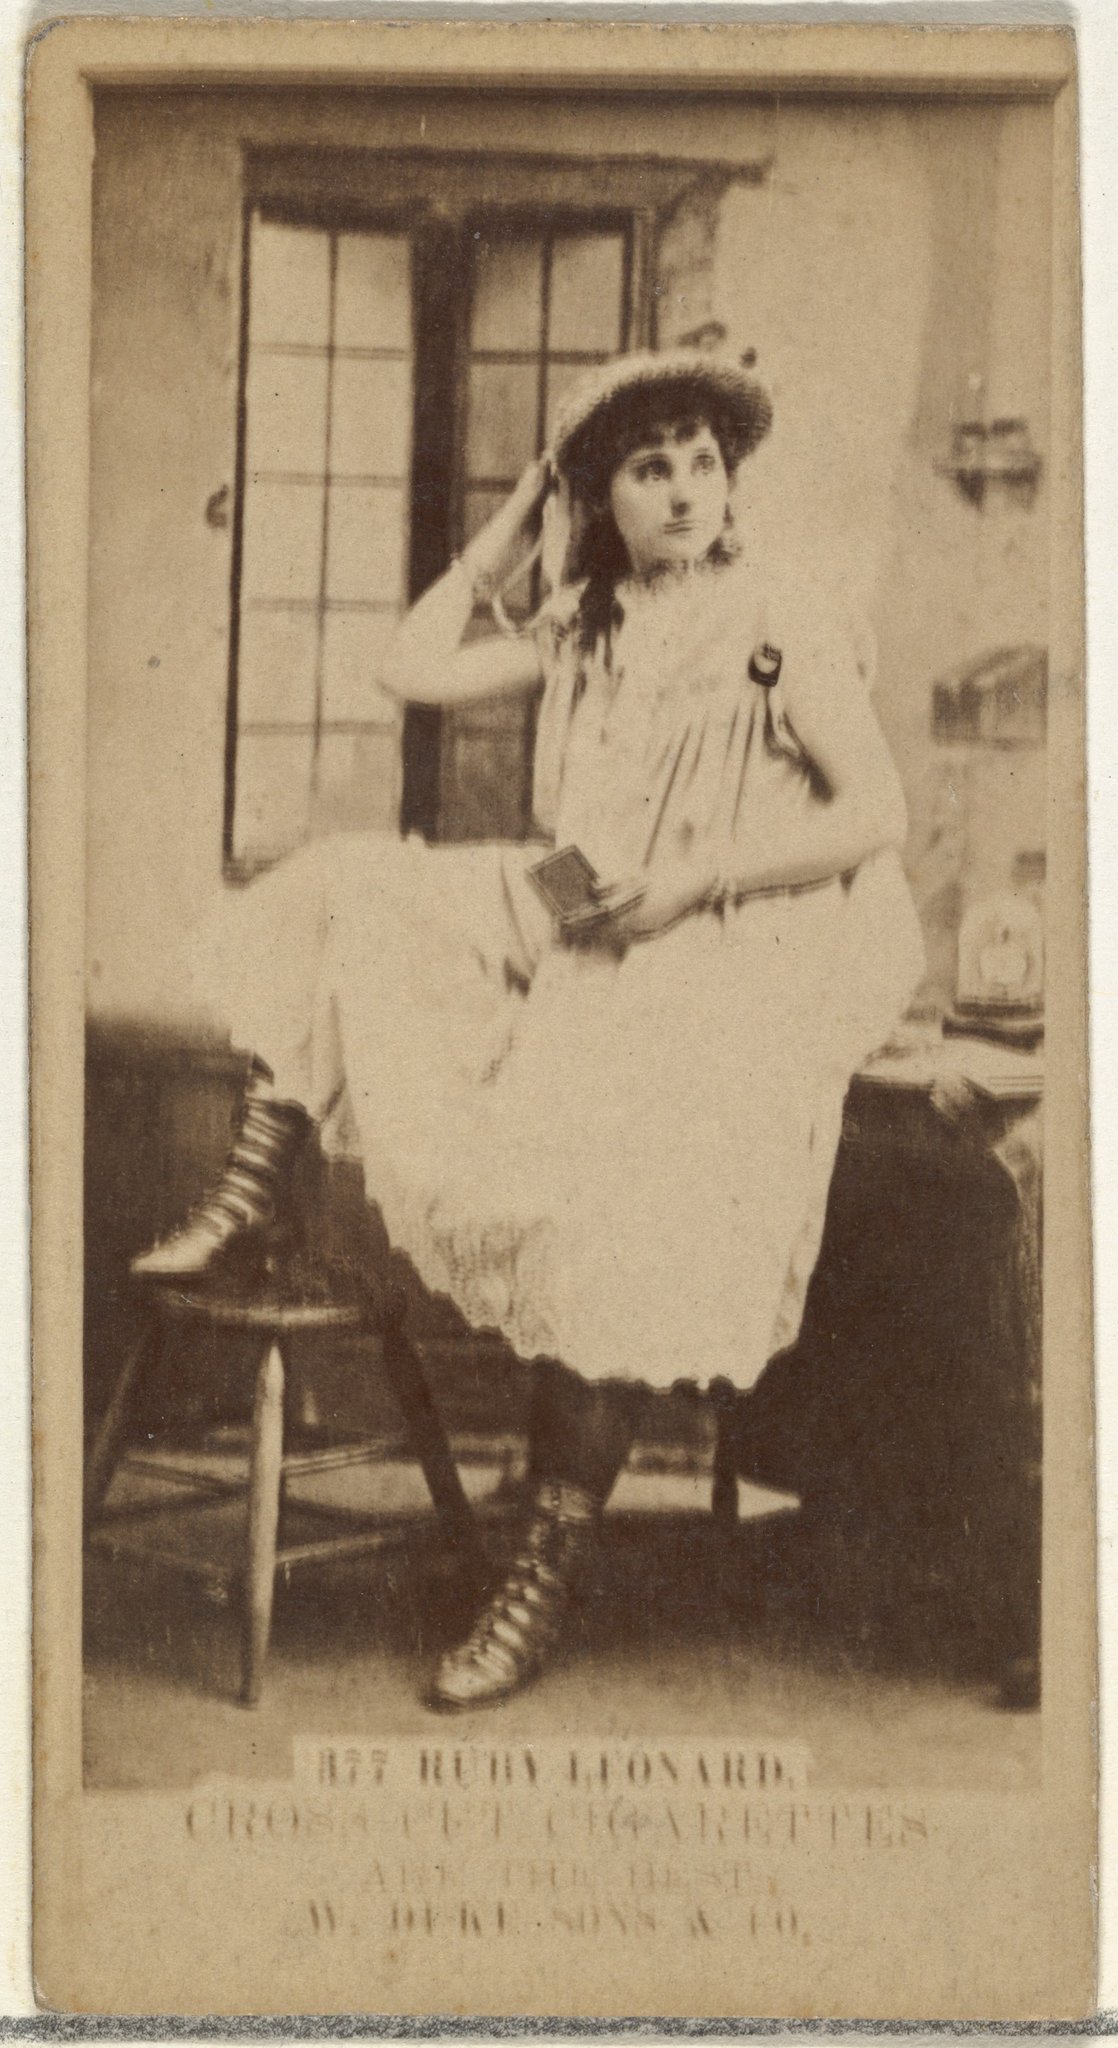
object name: photograph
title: Card Number 377, Ruby Leonard, from the Actors and Actresses series (N145-3) issued by Duke Sons & Co. to promote Cross Cut Cigarettes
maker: w. duke, sons & co.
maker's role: publisher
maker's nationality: american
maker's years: 1870-1920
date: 1880-1889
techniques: albumen silver print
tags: portraits,women,actresses